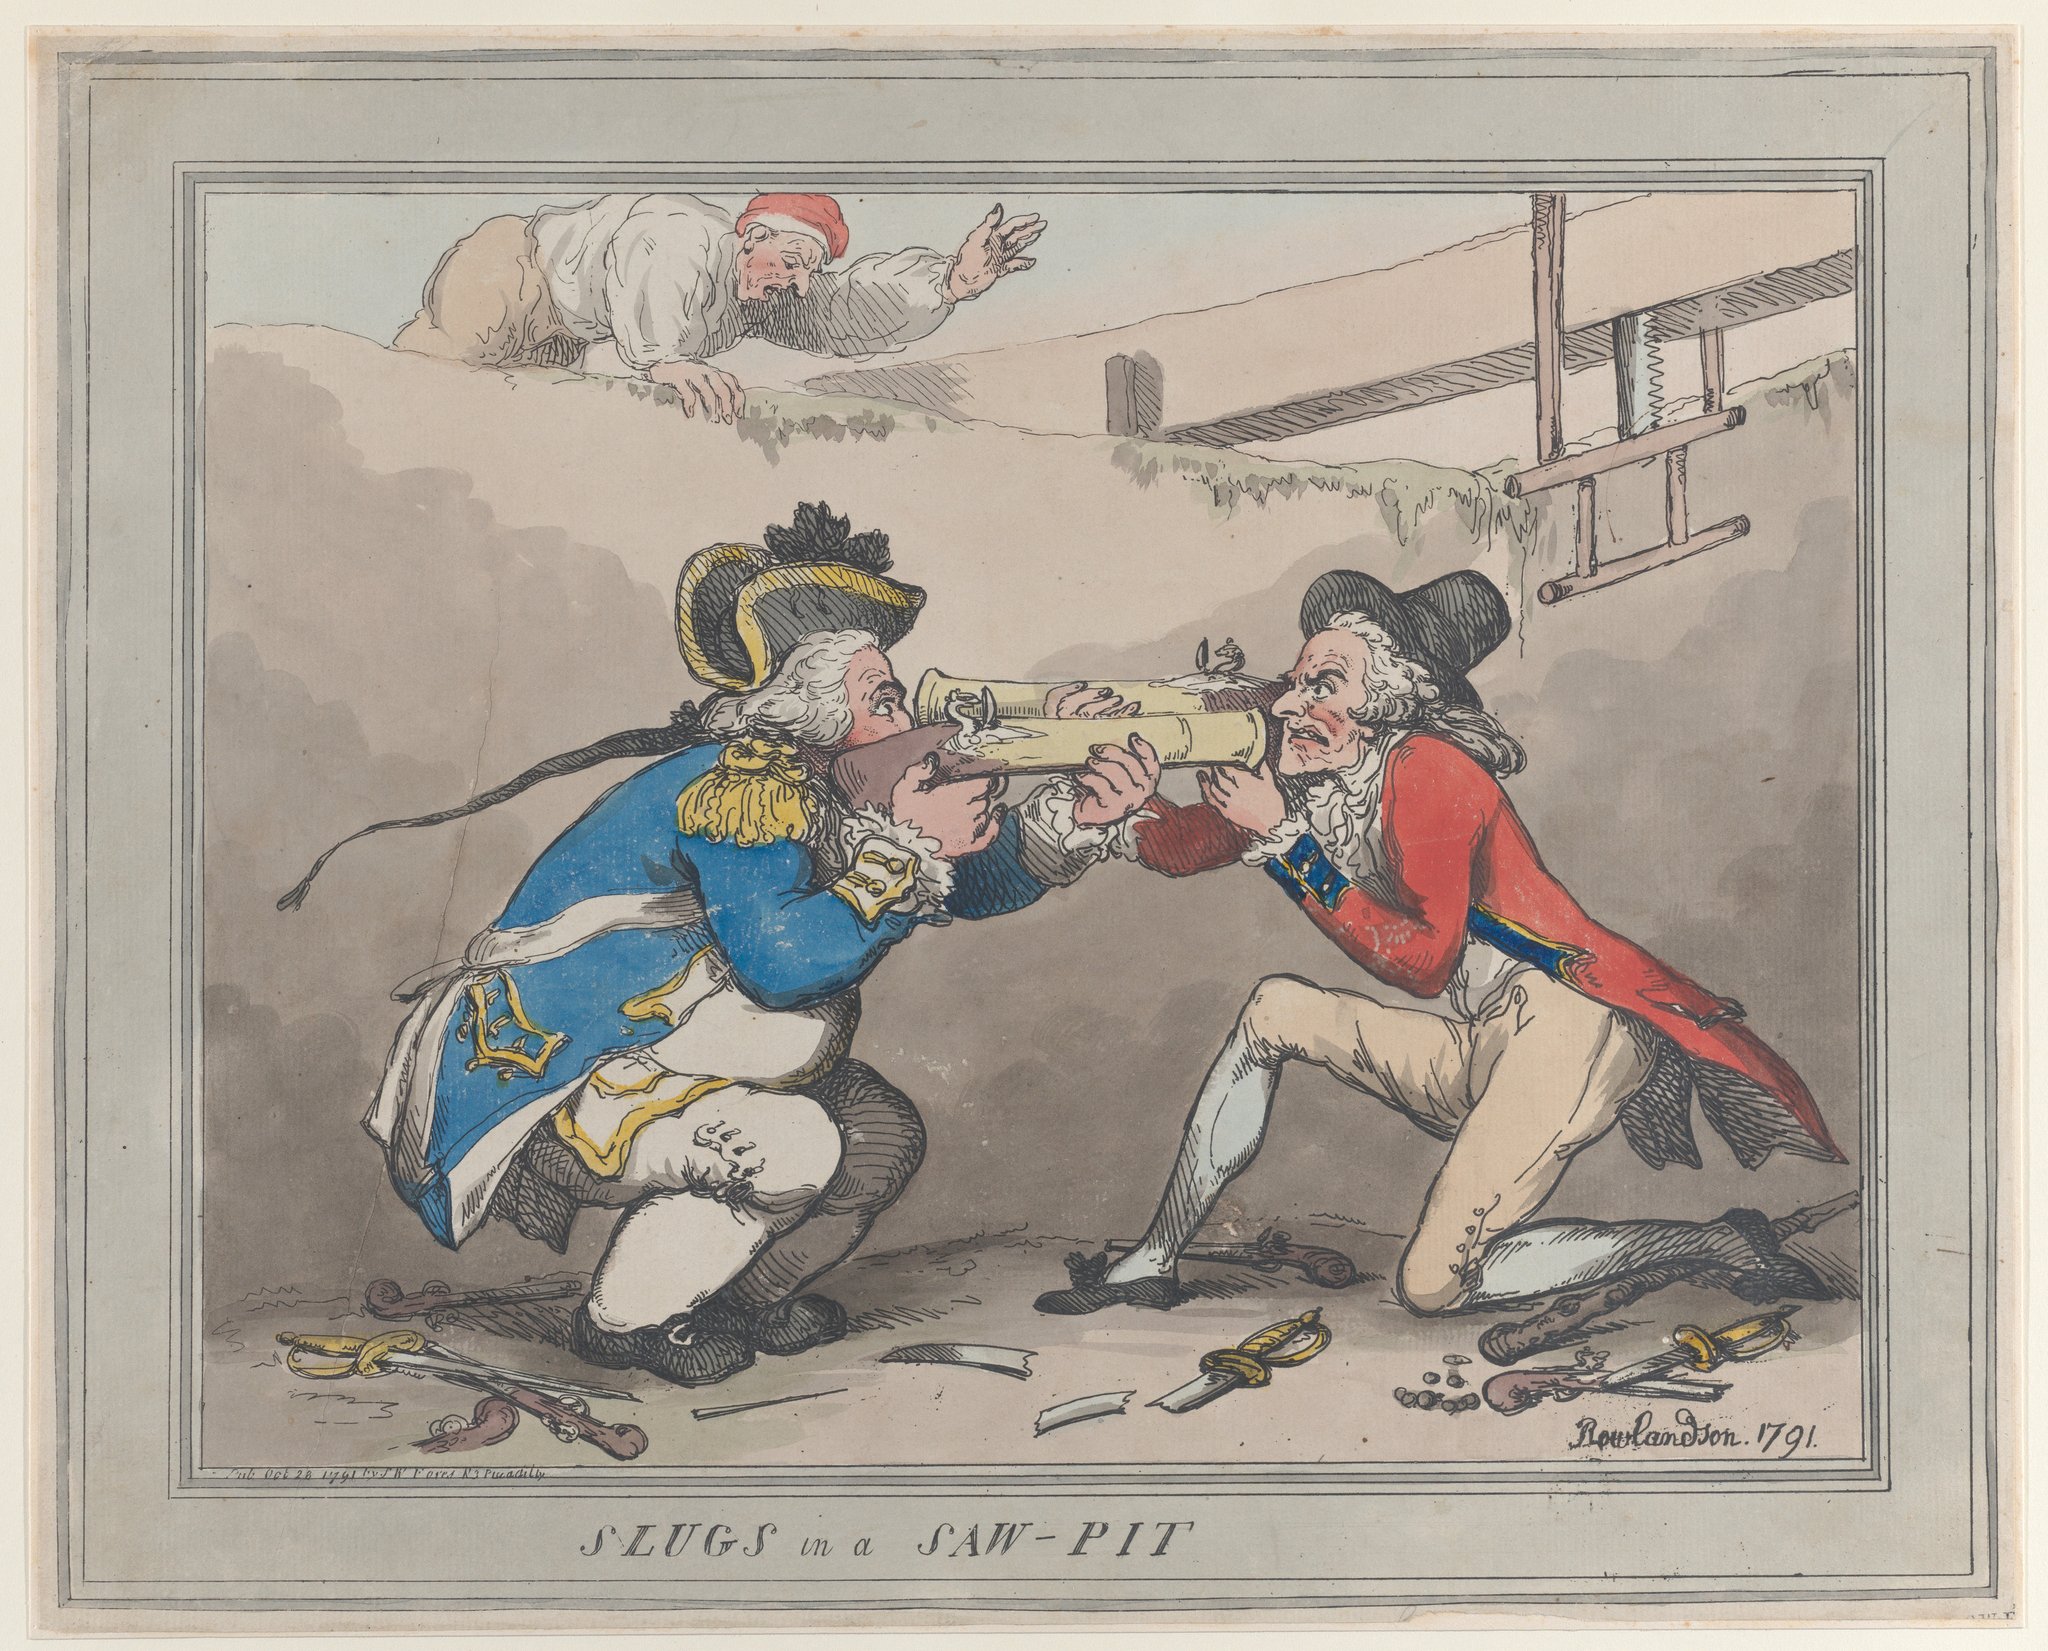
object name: print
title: Slugs in a Saw-Pit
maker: thomas rowlandson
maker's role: artist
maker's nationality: british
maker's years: 1757-1827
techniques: etching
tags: satire,firearms,men